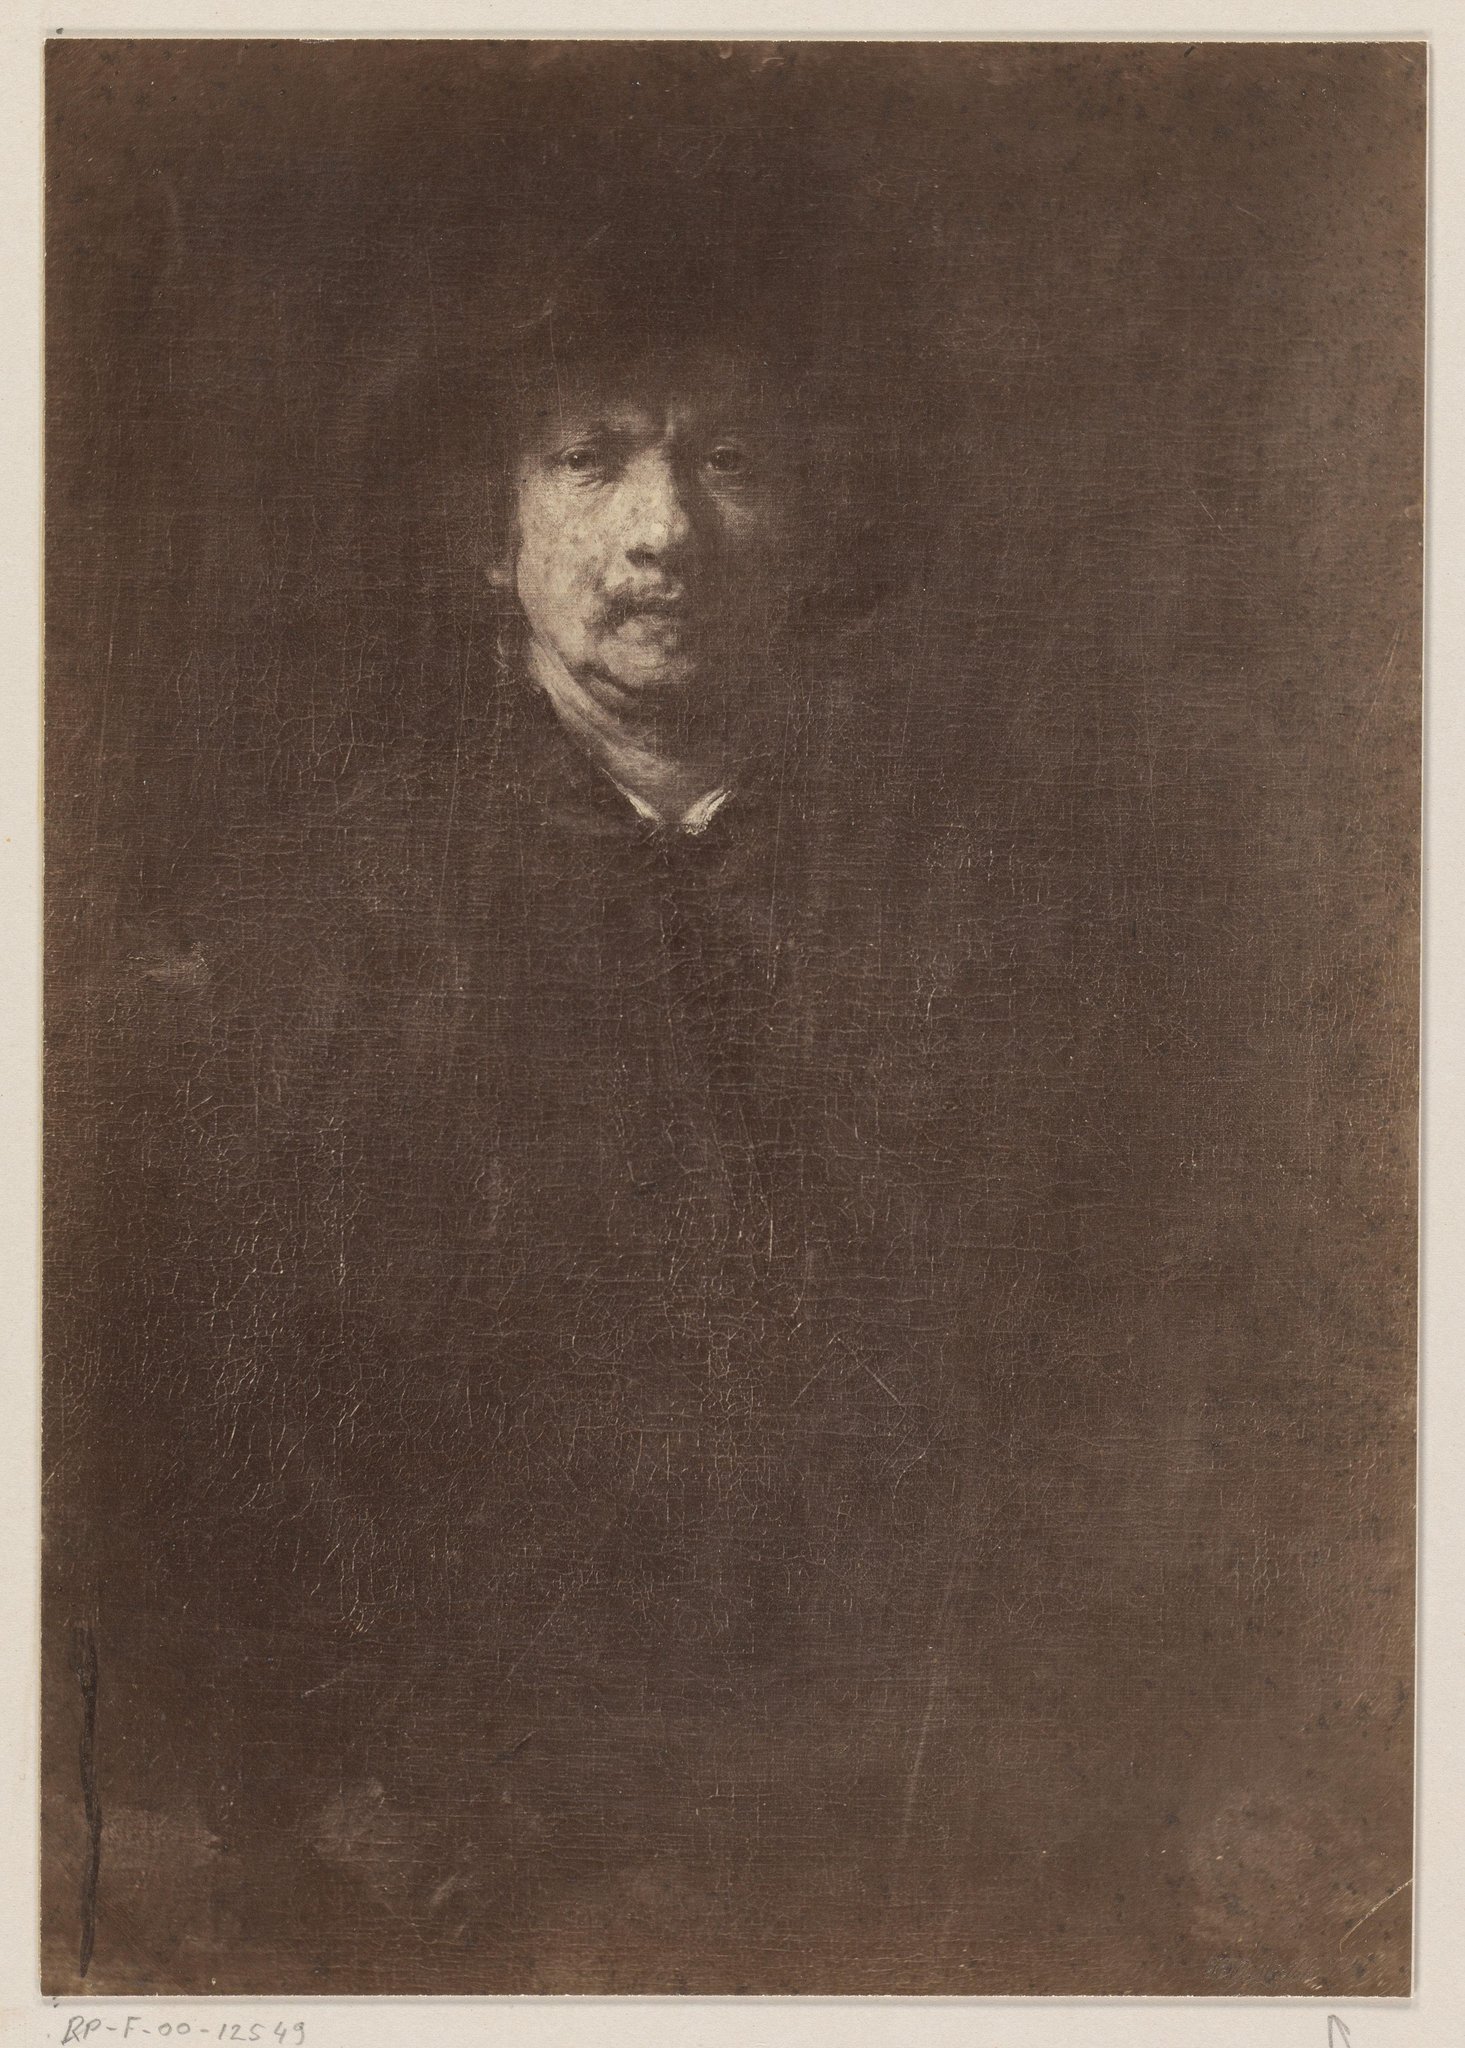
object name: reproduction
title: Fotoreproductie van een geschilderd zelfportret van Rembrandt van Rijn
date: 1874-1904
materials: cardboard, paper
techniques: albumen print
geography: vienna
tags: amsterdam, painter, print maker, draughtsman, rembrandt van rijn, historical persons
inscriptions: collector's mark: Lugt 964